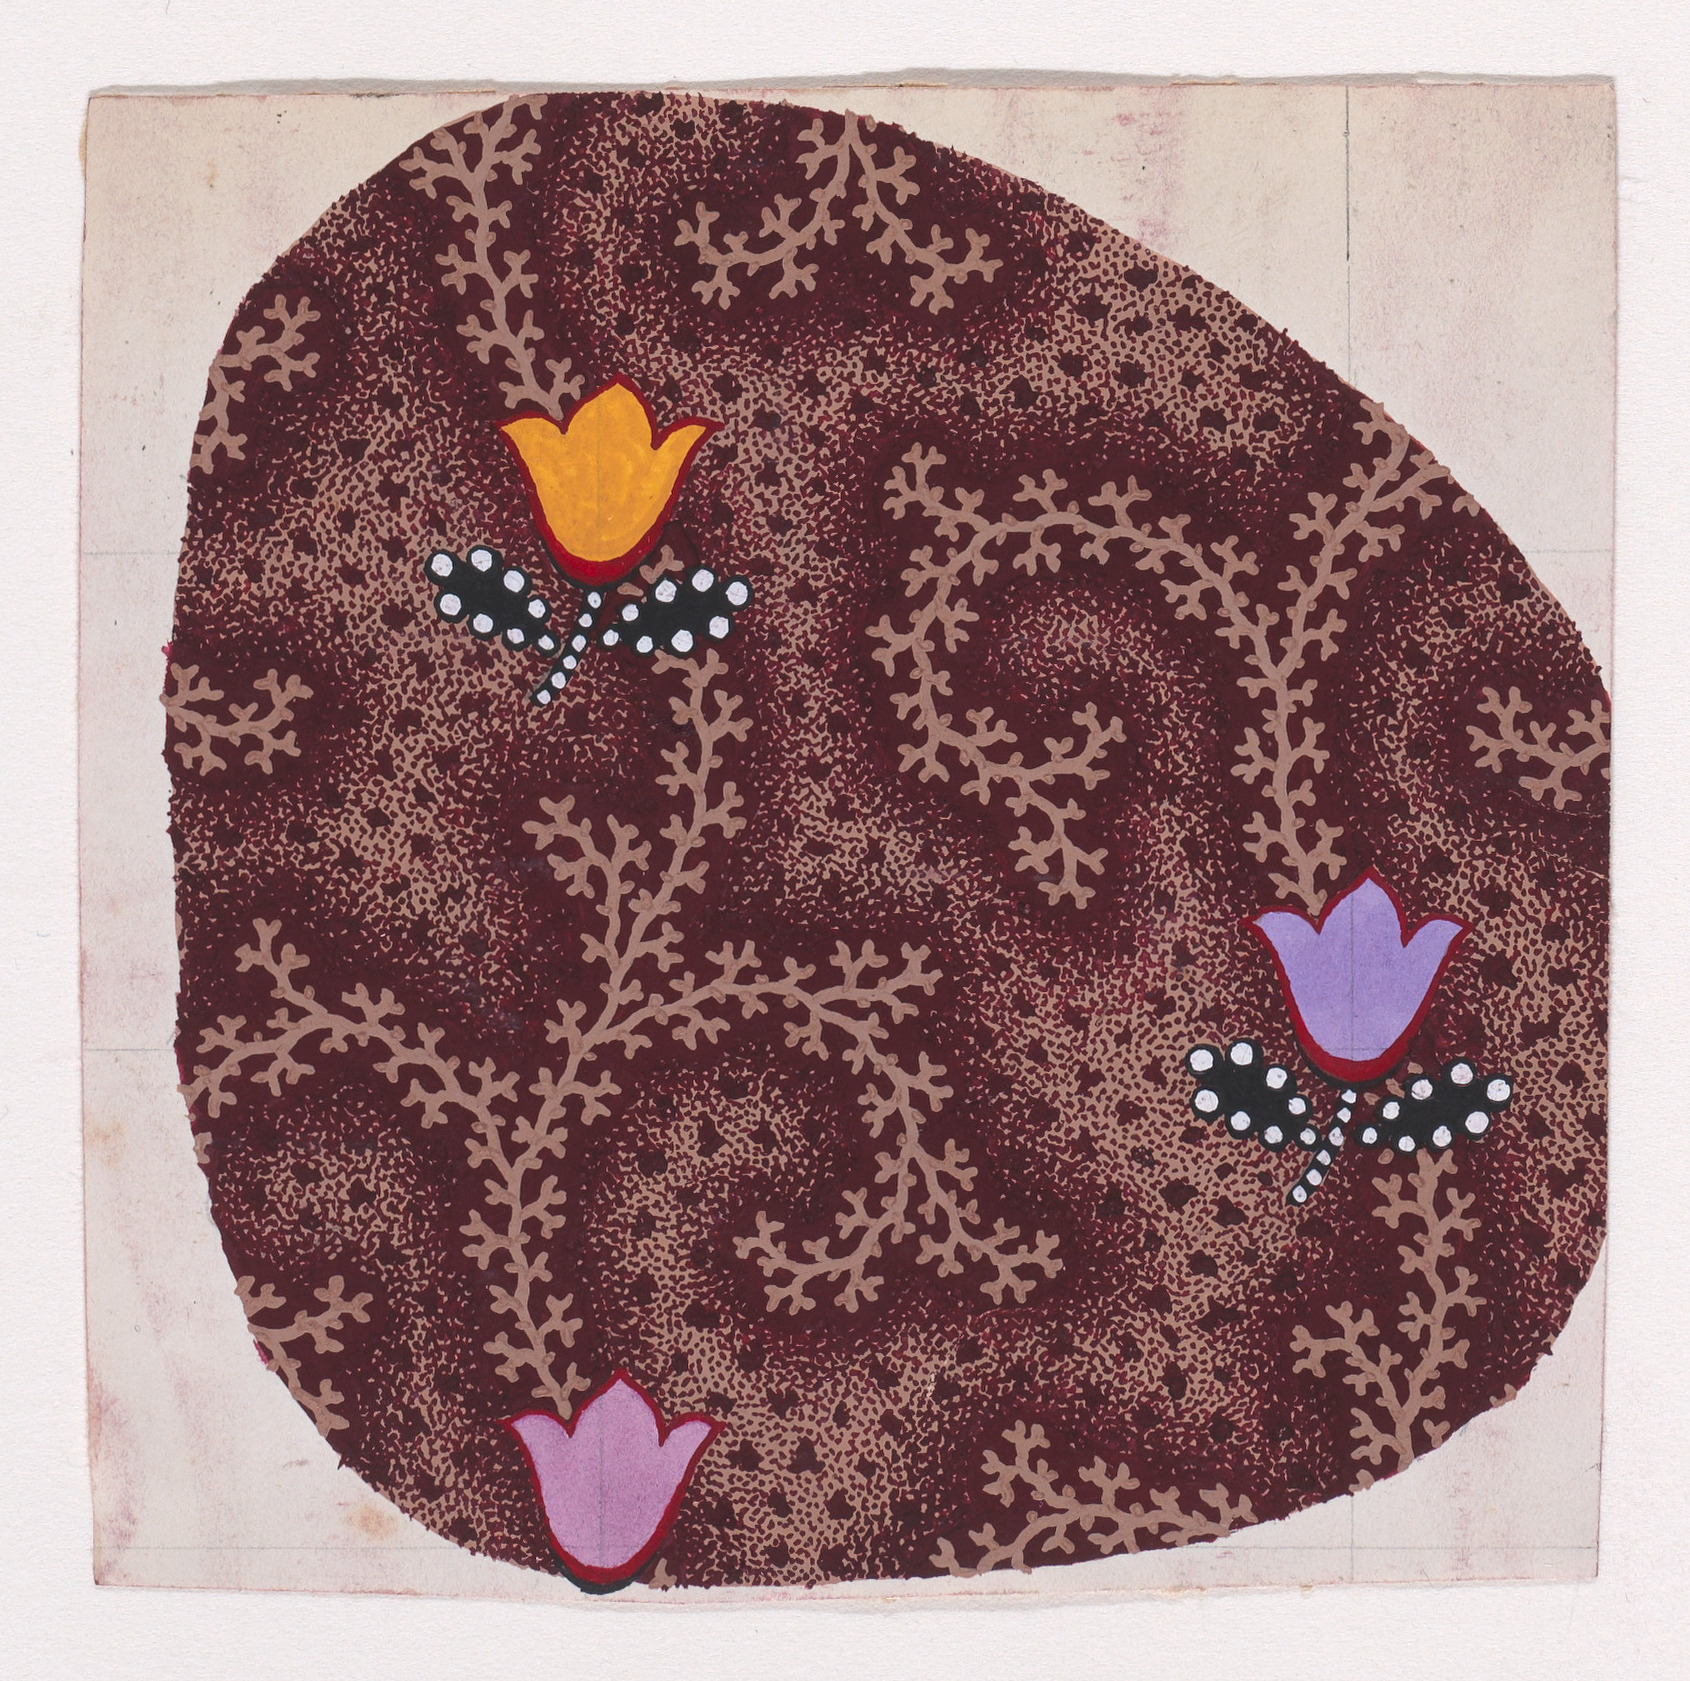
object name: drawing ornament architecture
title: Textile Design with Vertical Scrolling Garlands of Branches with Stylized Tulips and Pearls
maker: anonymous, alsatian, 19th century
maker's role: artist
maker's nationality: alsatian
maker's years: 1800-1900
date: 1840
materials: gouache